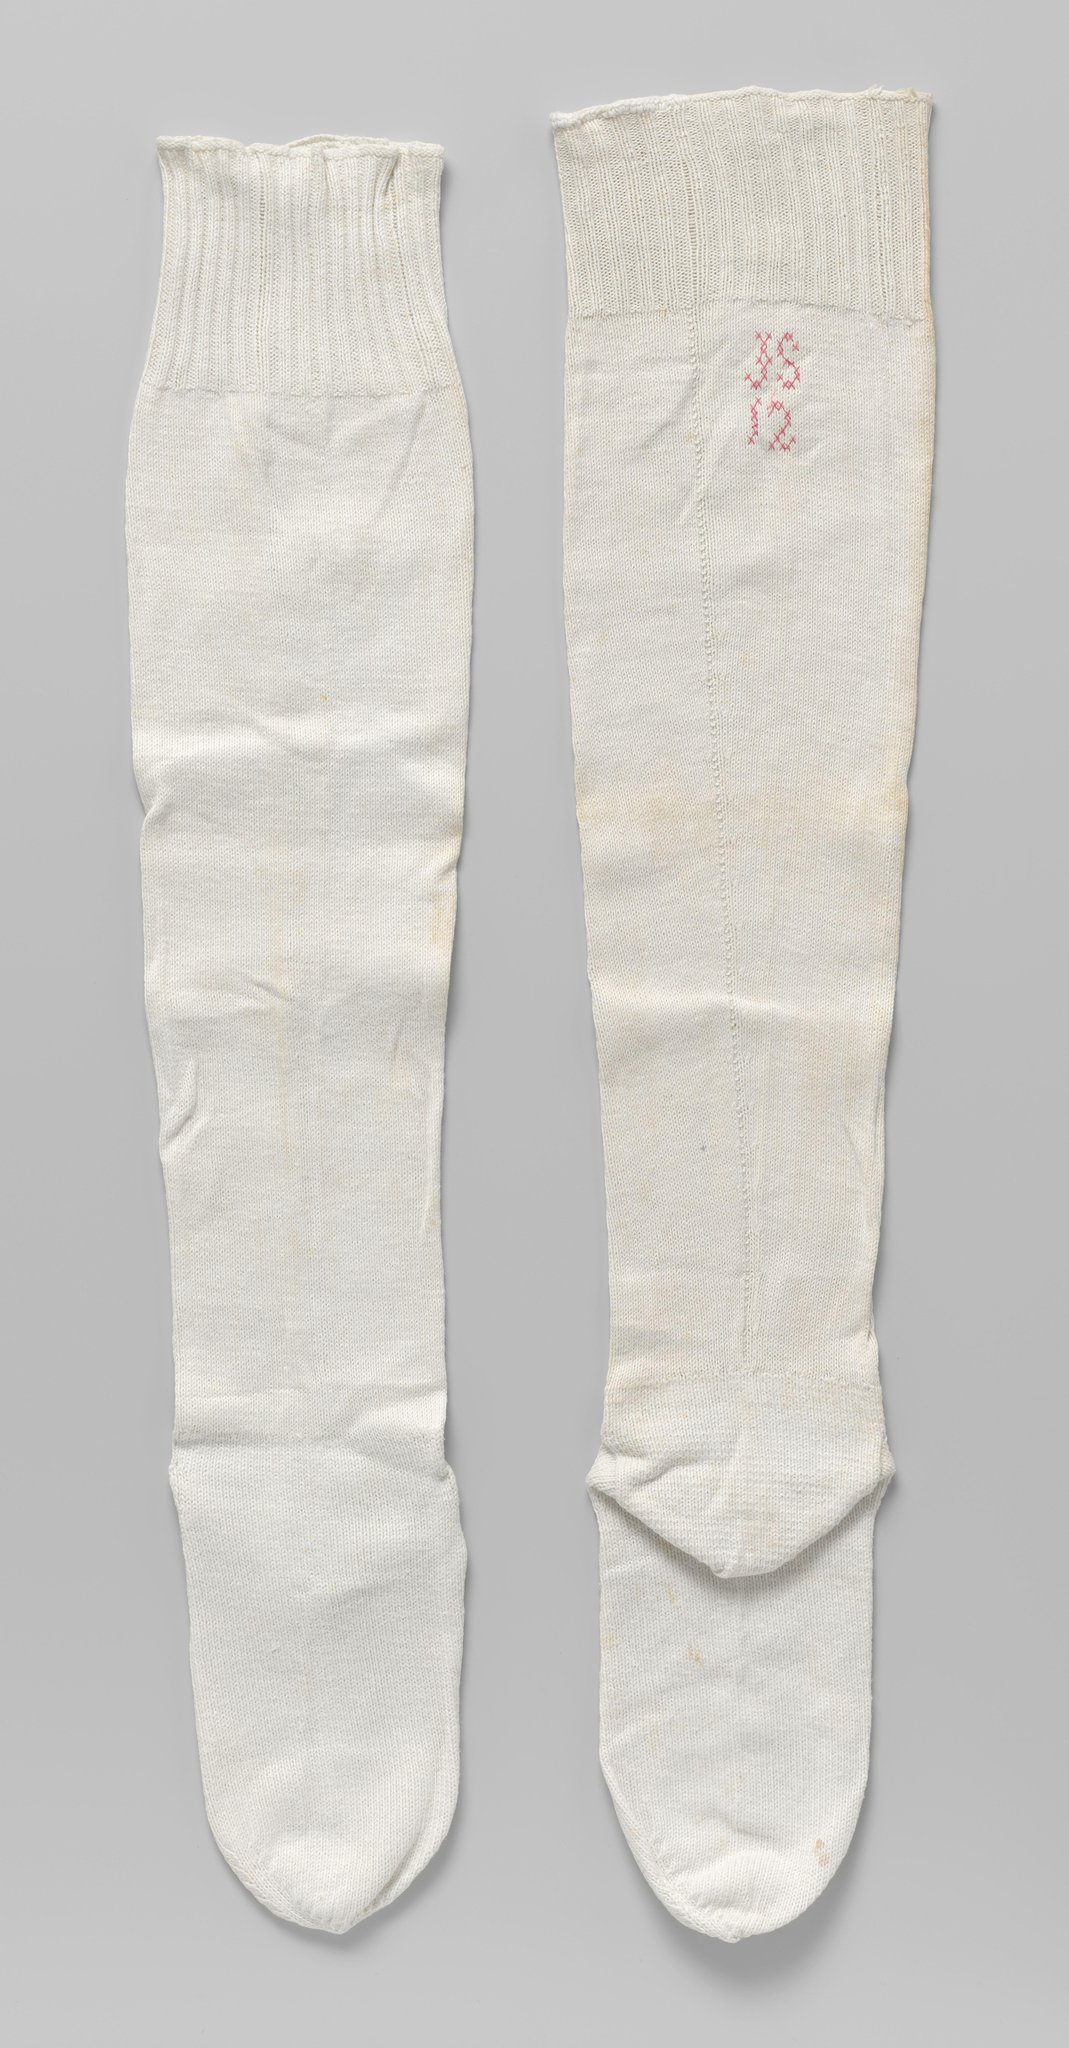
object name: stocking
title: Herenkous van wit katoenen breiwerk, in rode kruissteek gemerkt: JS / 12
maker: Anonymous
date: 1875-1925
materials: cotton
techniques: cross stitching, knitting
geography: amsterdam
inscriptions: initials: ‘JS / 12’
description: Herenkous van wit katoenen breiwerk, in rode kruissteek gemerkt: JS / 12.